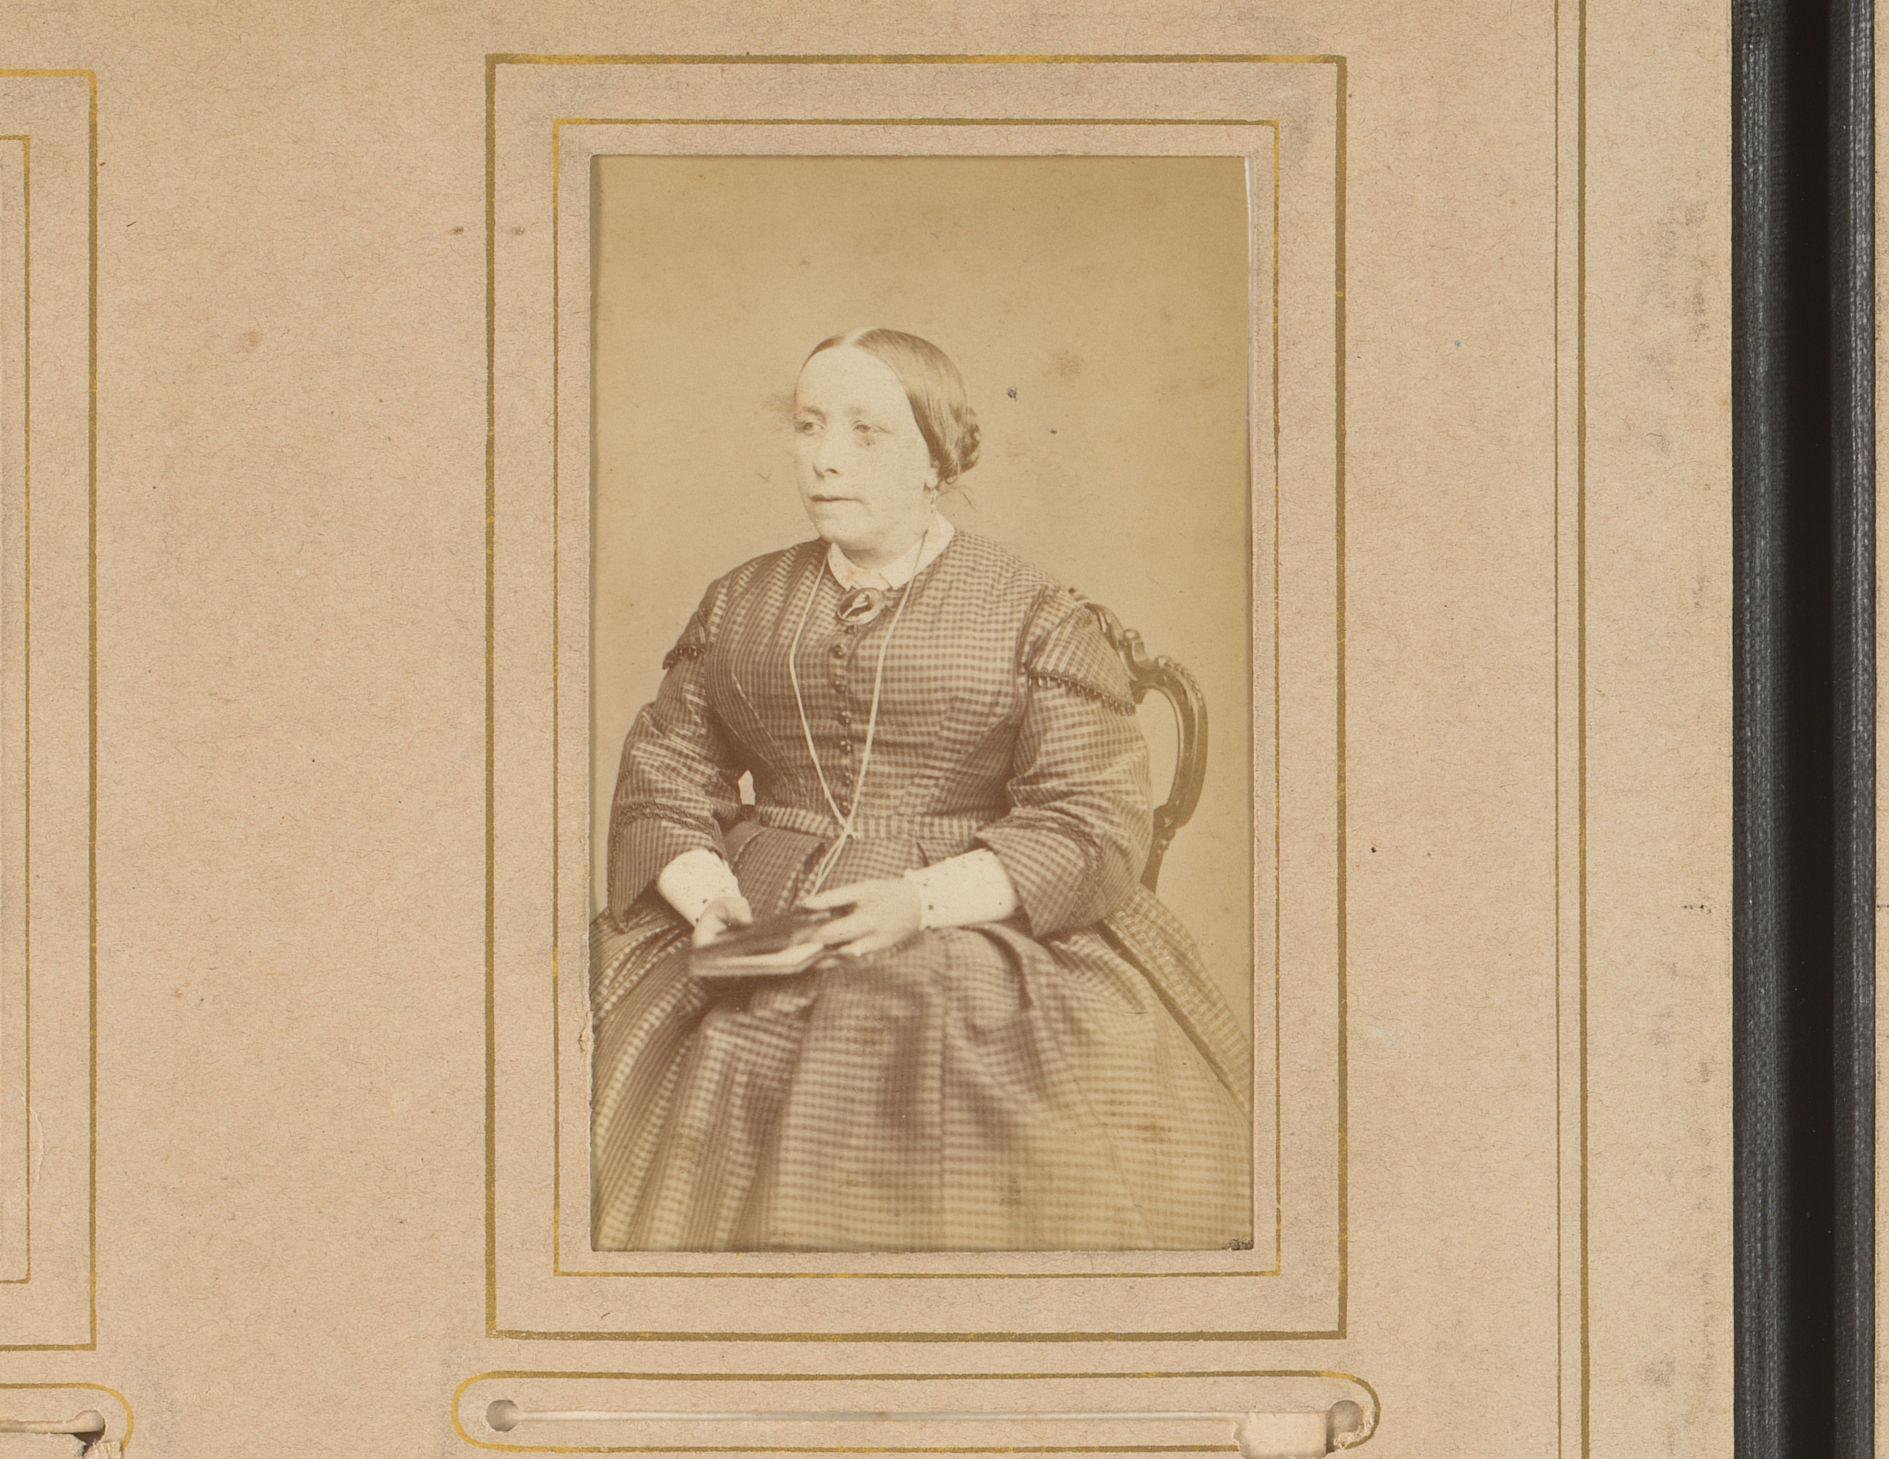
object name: album leaf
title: Portret van een vrouw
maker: Anonymous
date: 1860-1900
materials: cardboard, photographic support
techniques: albumen print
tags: adult woman, historical persons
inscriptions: inscription: ‘39 Canal des Recollets 39’